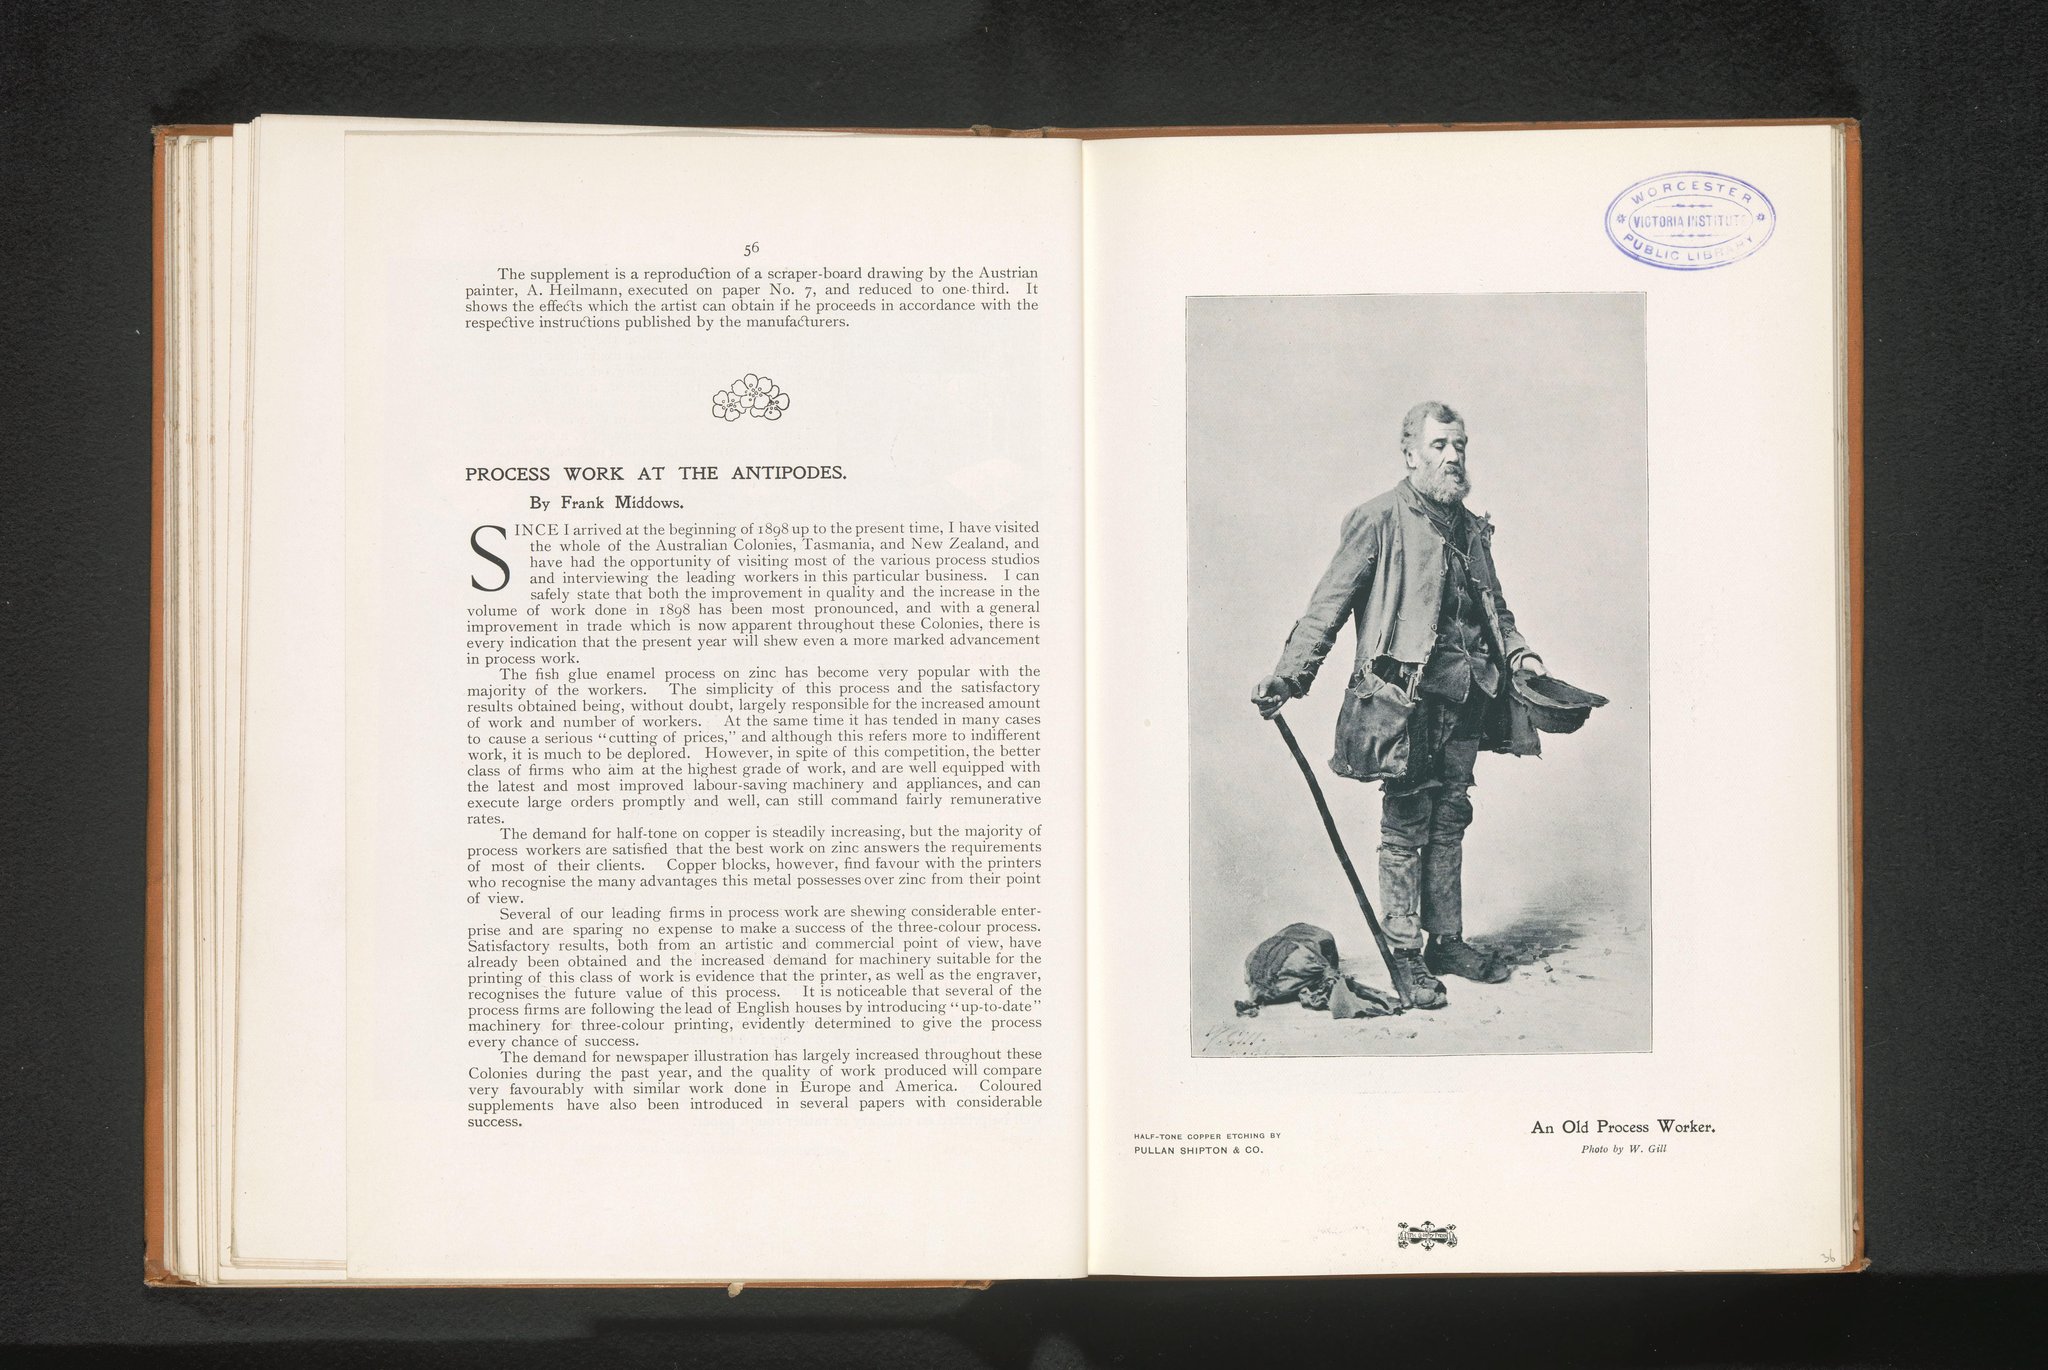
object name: photomechanical print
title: An old process worker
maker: william gill (fotograaf)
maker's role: fotograaf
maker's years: 1854-1912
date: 1894-1899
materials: paper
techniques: autotype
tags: old man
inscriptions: collector's mark: ‘Worcester Public Library/ Victoria's Institute’